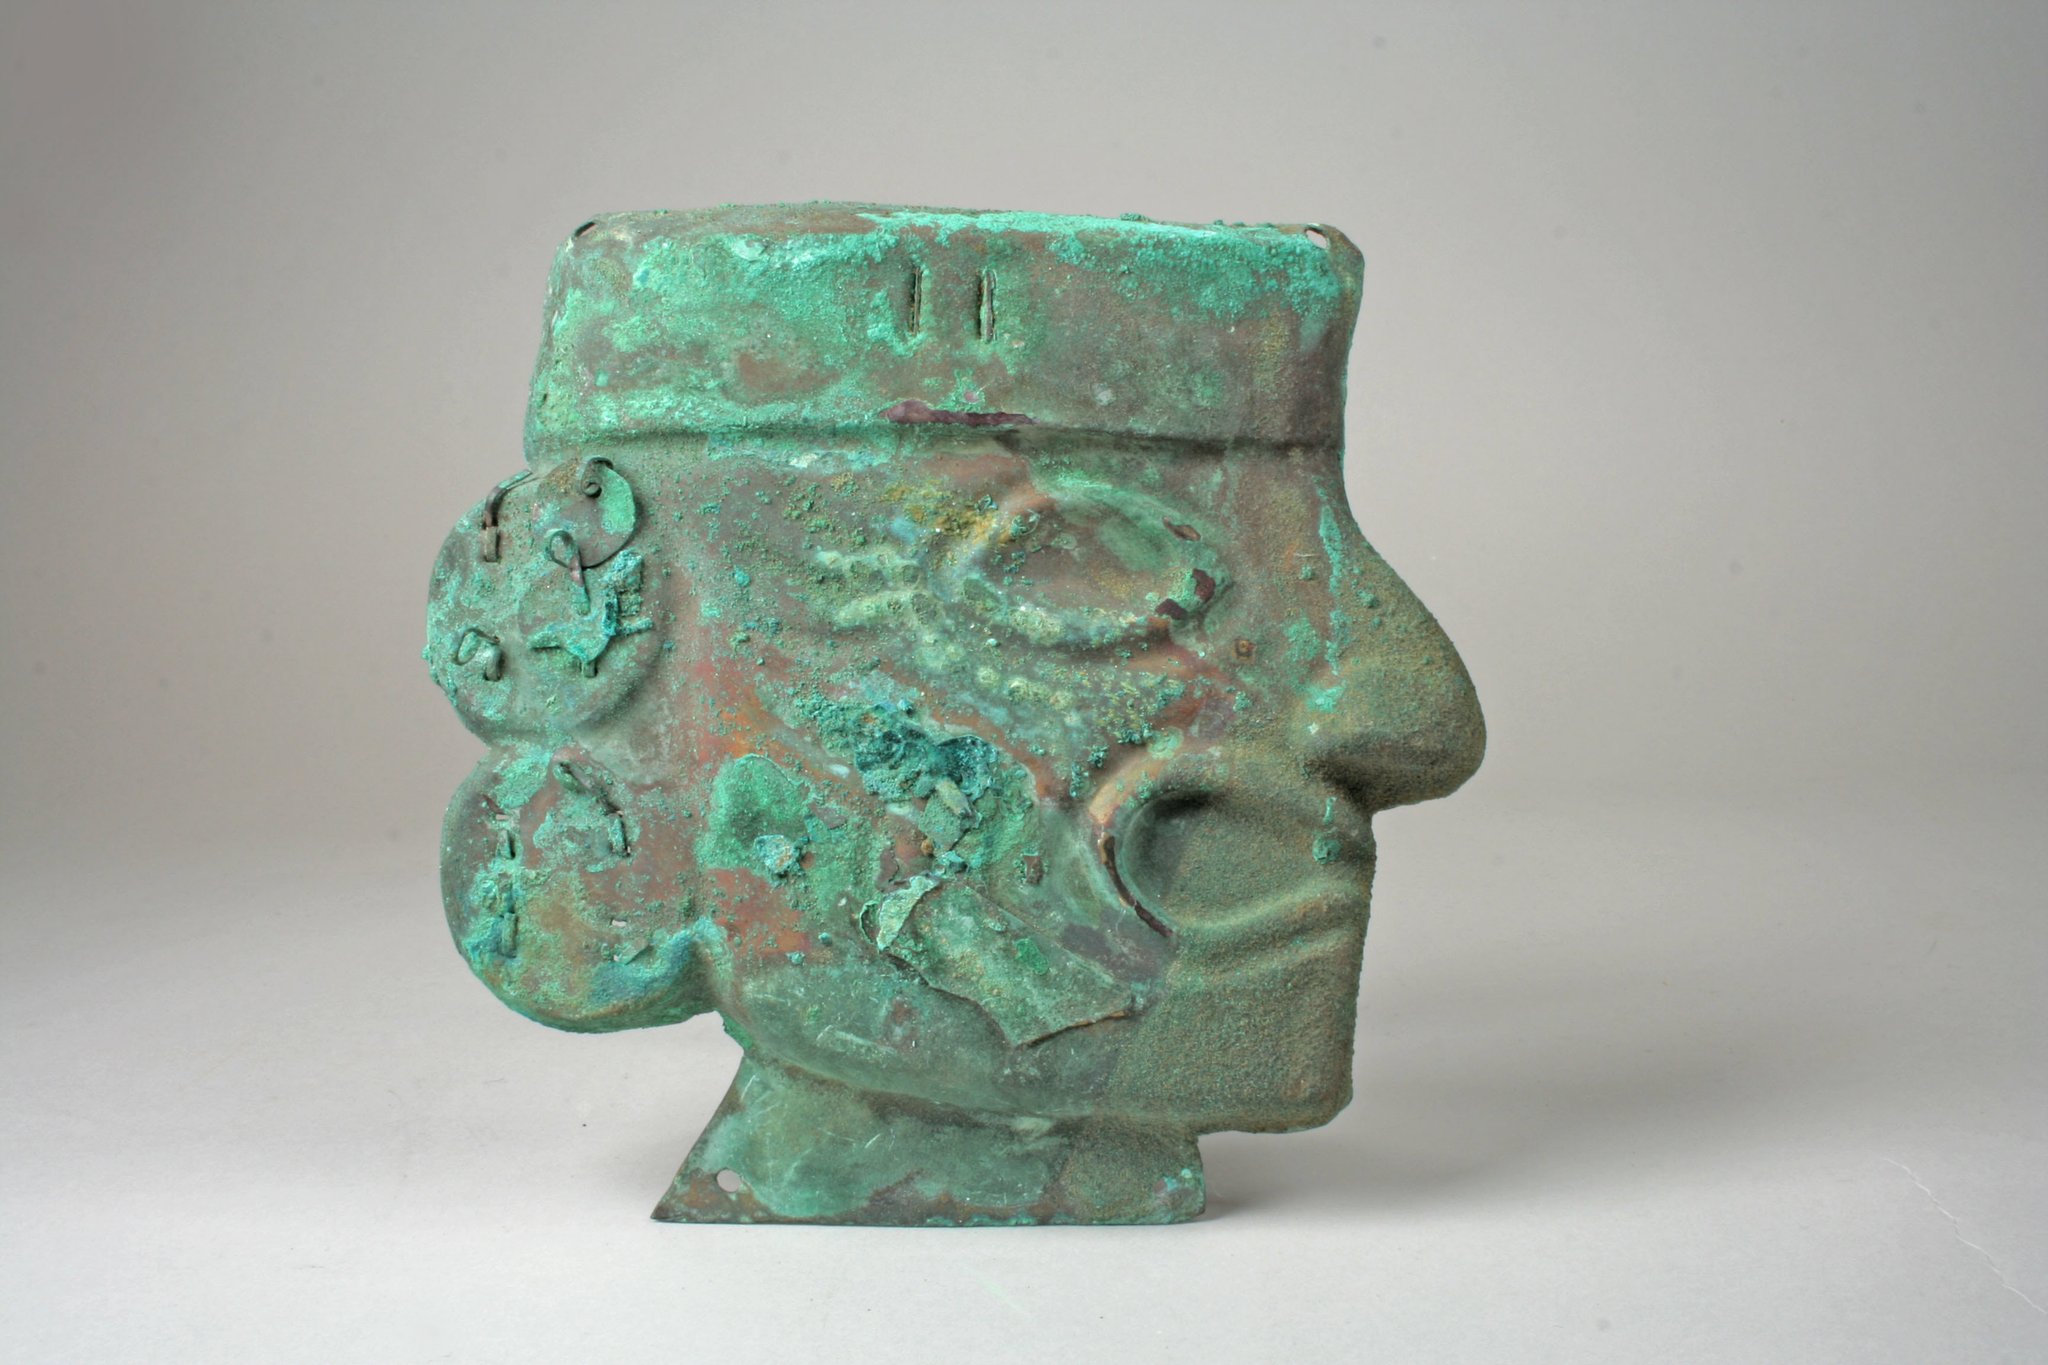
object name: ornament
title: Profile Face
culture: moche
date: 501-700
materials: metal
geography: peru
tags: faces,profiles